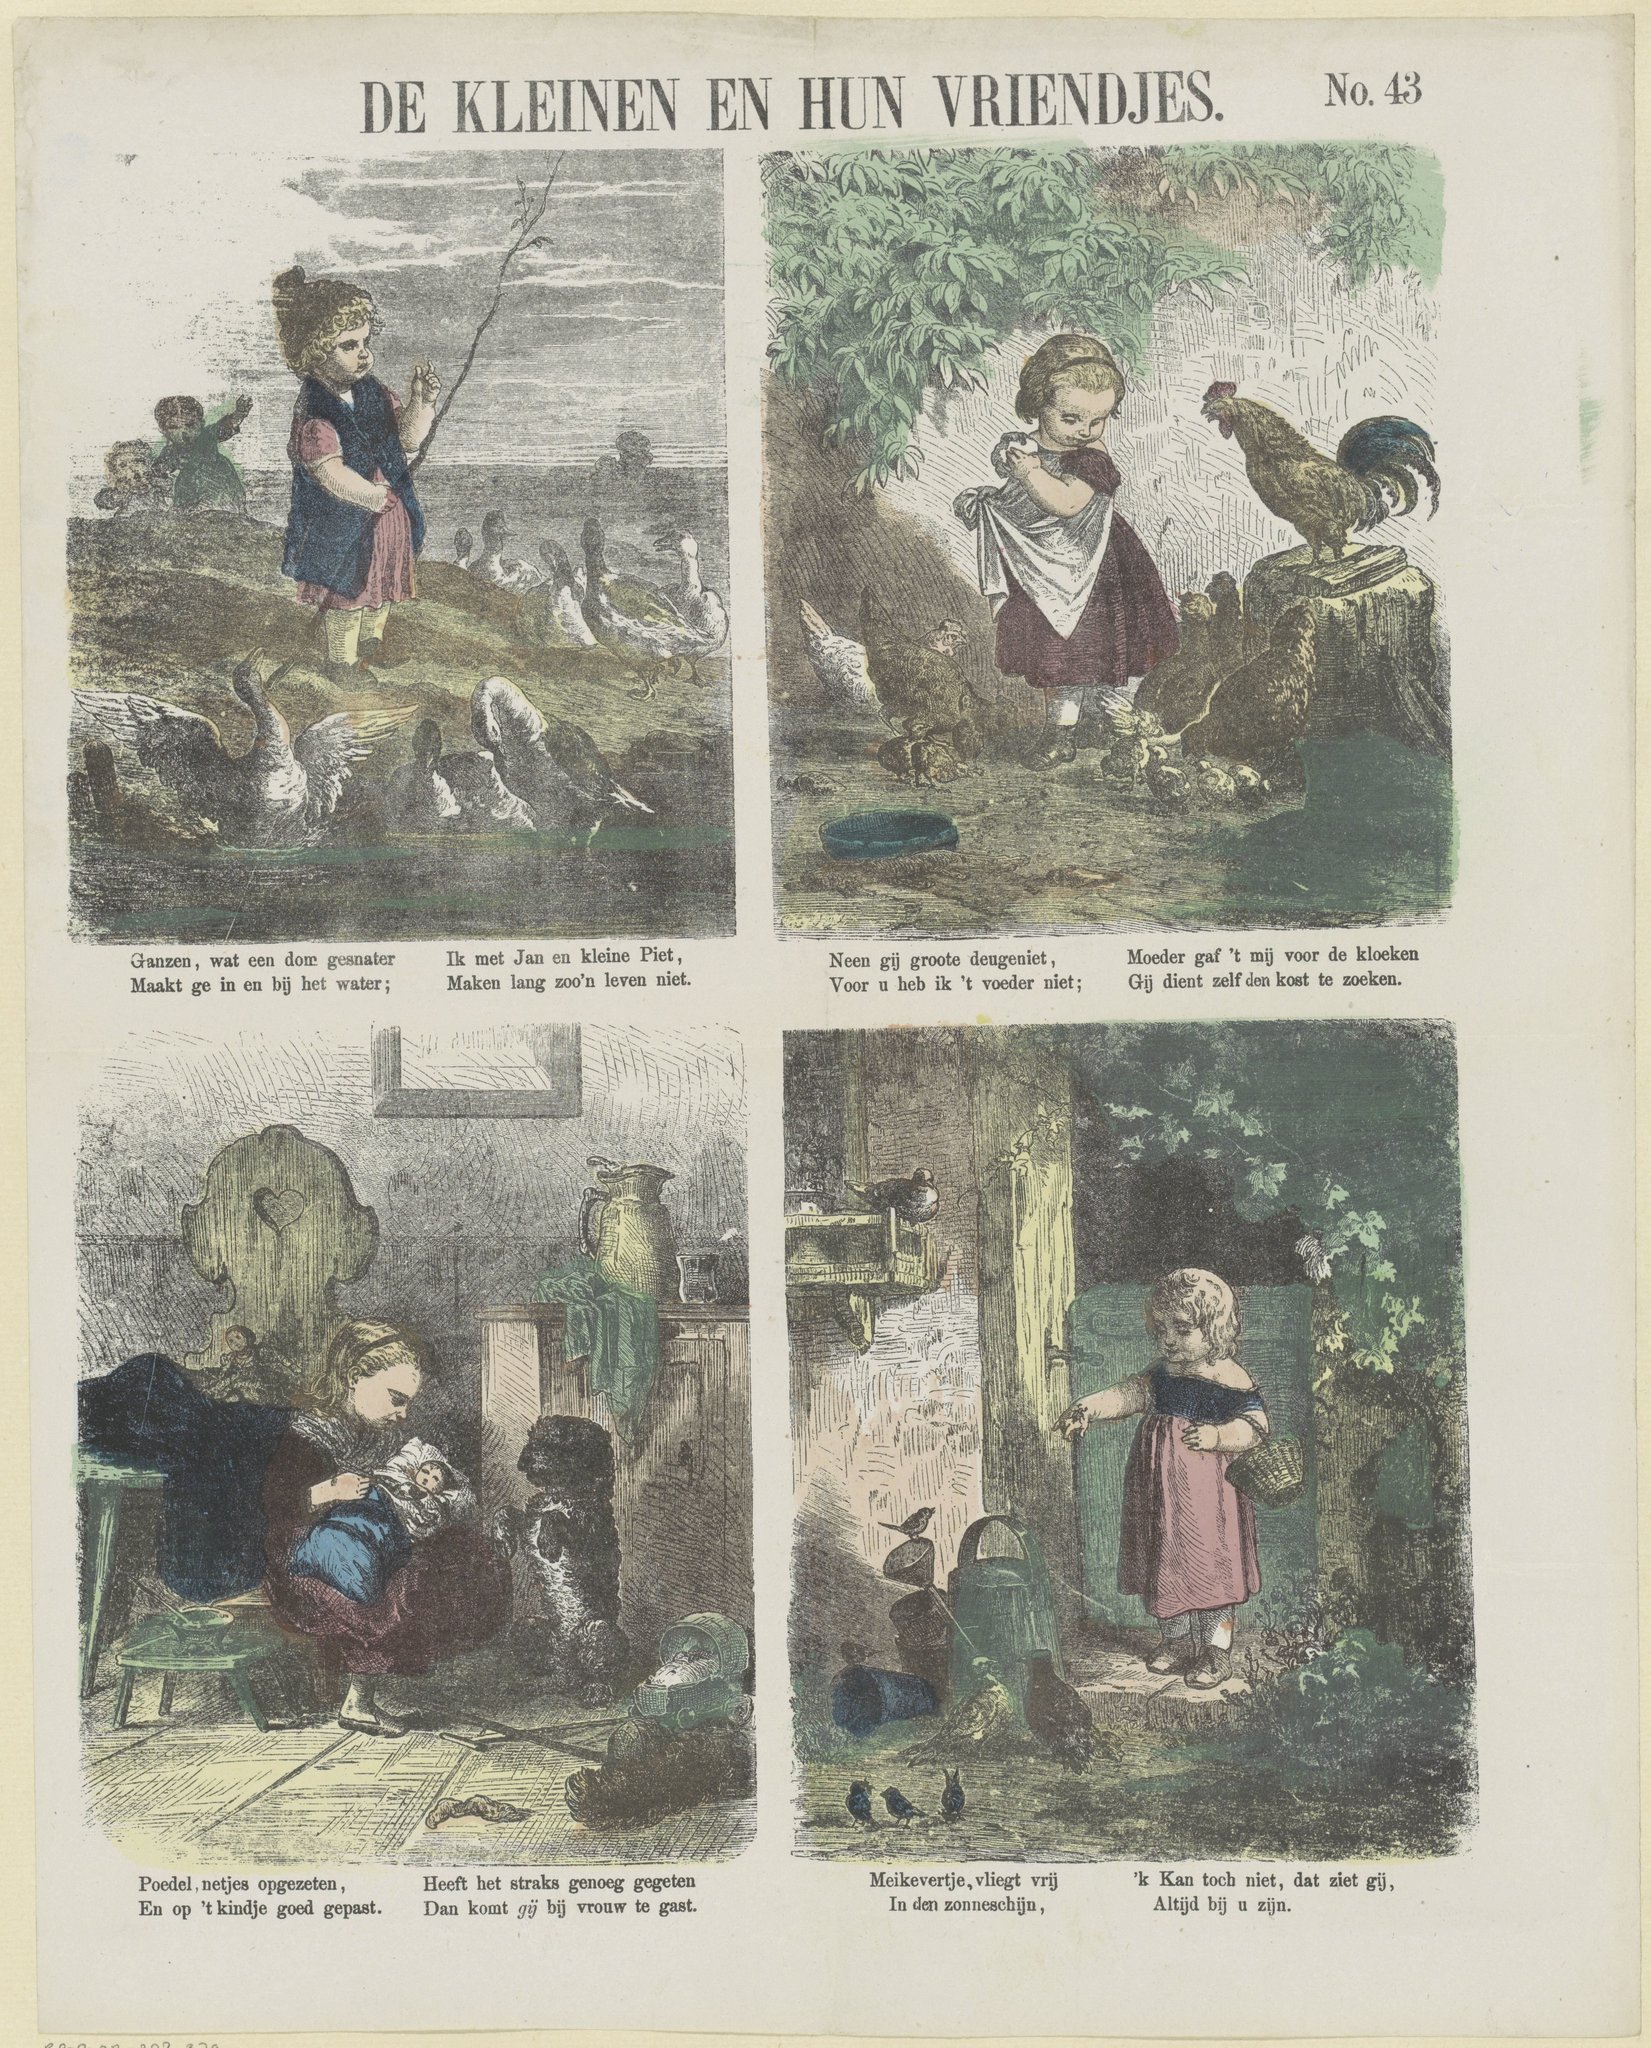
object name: popular print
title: De kleinen en hun vriendjes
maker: Anonymous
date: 1874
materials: paper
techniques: colour, letterpress printing, lithograph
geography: amsterdam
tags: animals, child, child playing with animals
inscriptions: collector's mark: Lugt 2760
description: Blad met 4 voorstellingen van kinderen die met dieren spelen. Onder elke afbeelding een vierregelig vers in twee kolommen. Genummerd rechtsboven: No. 43.